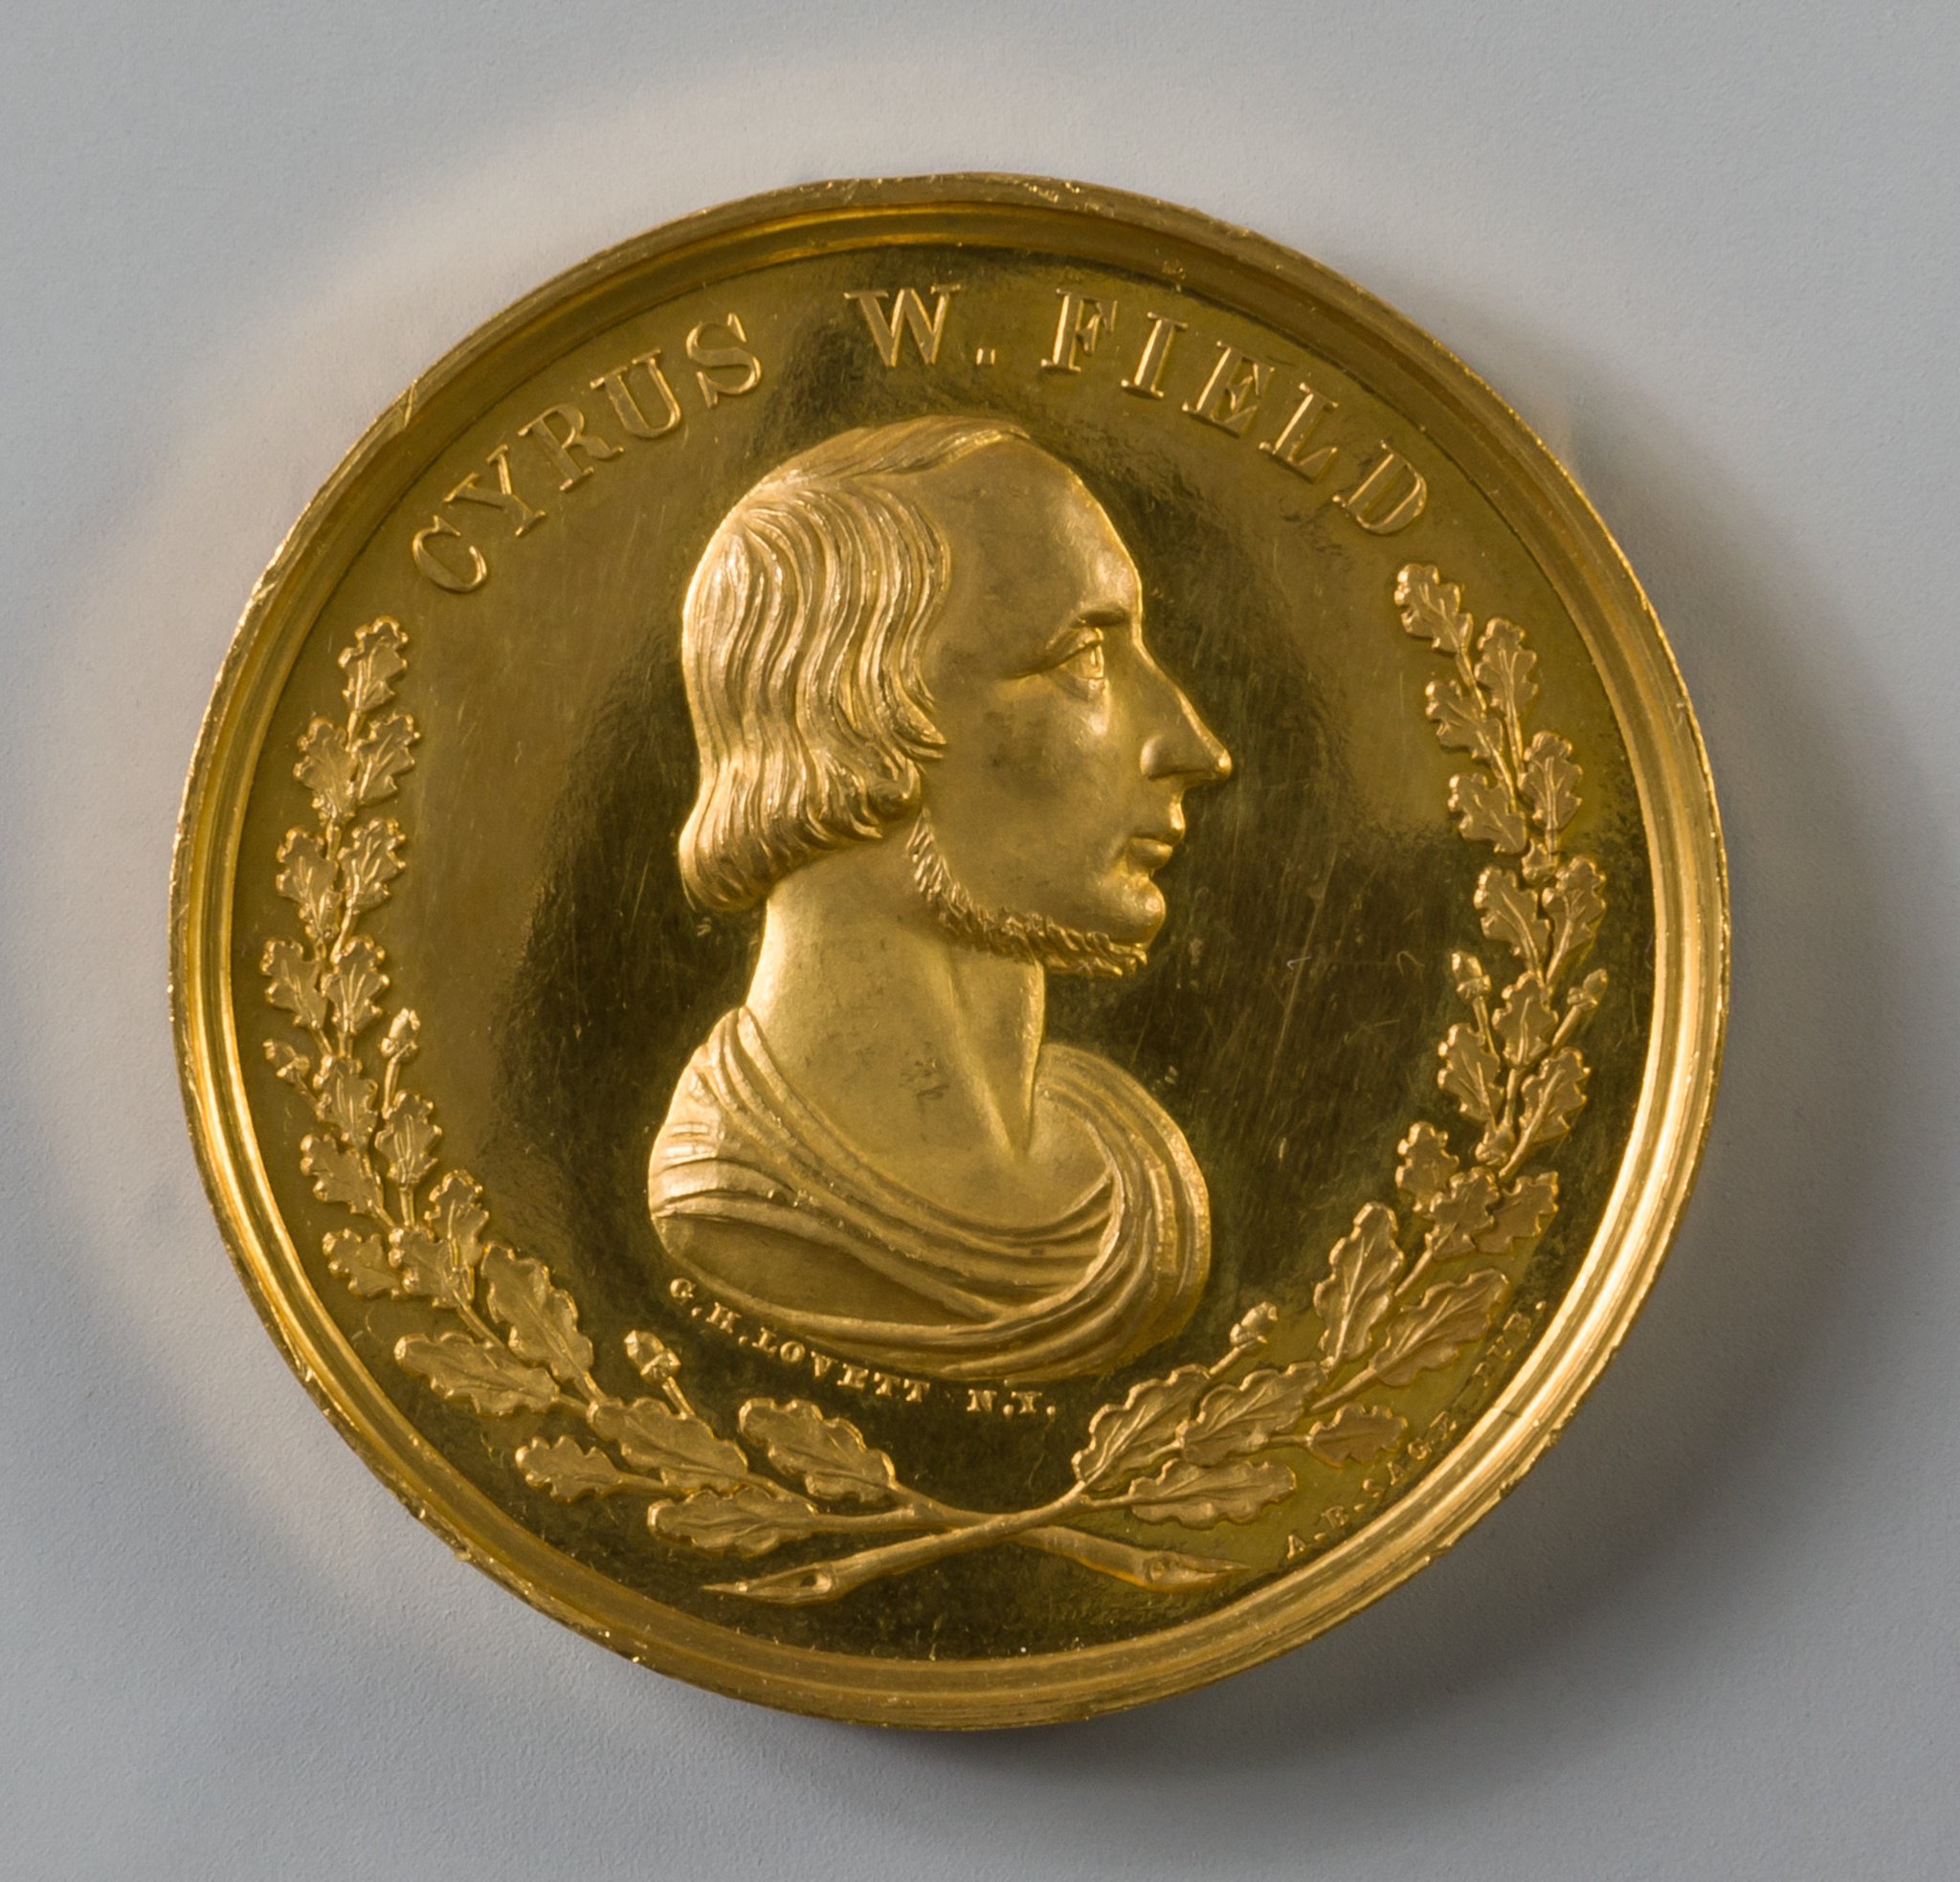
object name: medal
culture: american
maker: george hampden lovett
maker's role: maker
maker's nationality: american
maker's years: 1824-1894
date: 1858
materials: gold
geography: united states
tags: men,profiles,transatlantic cable